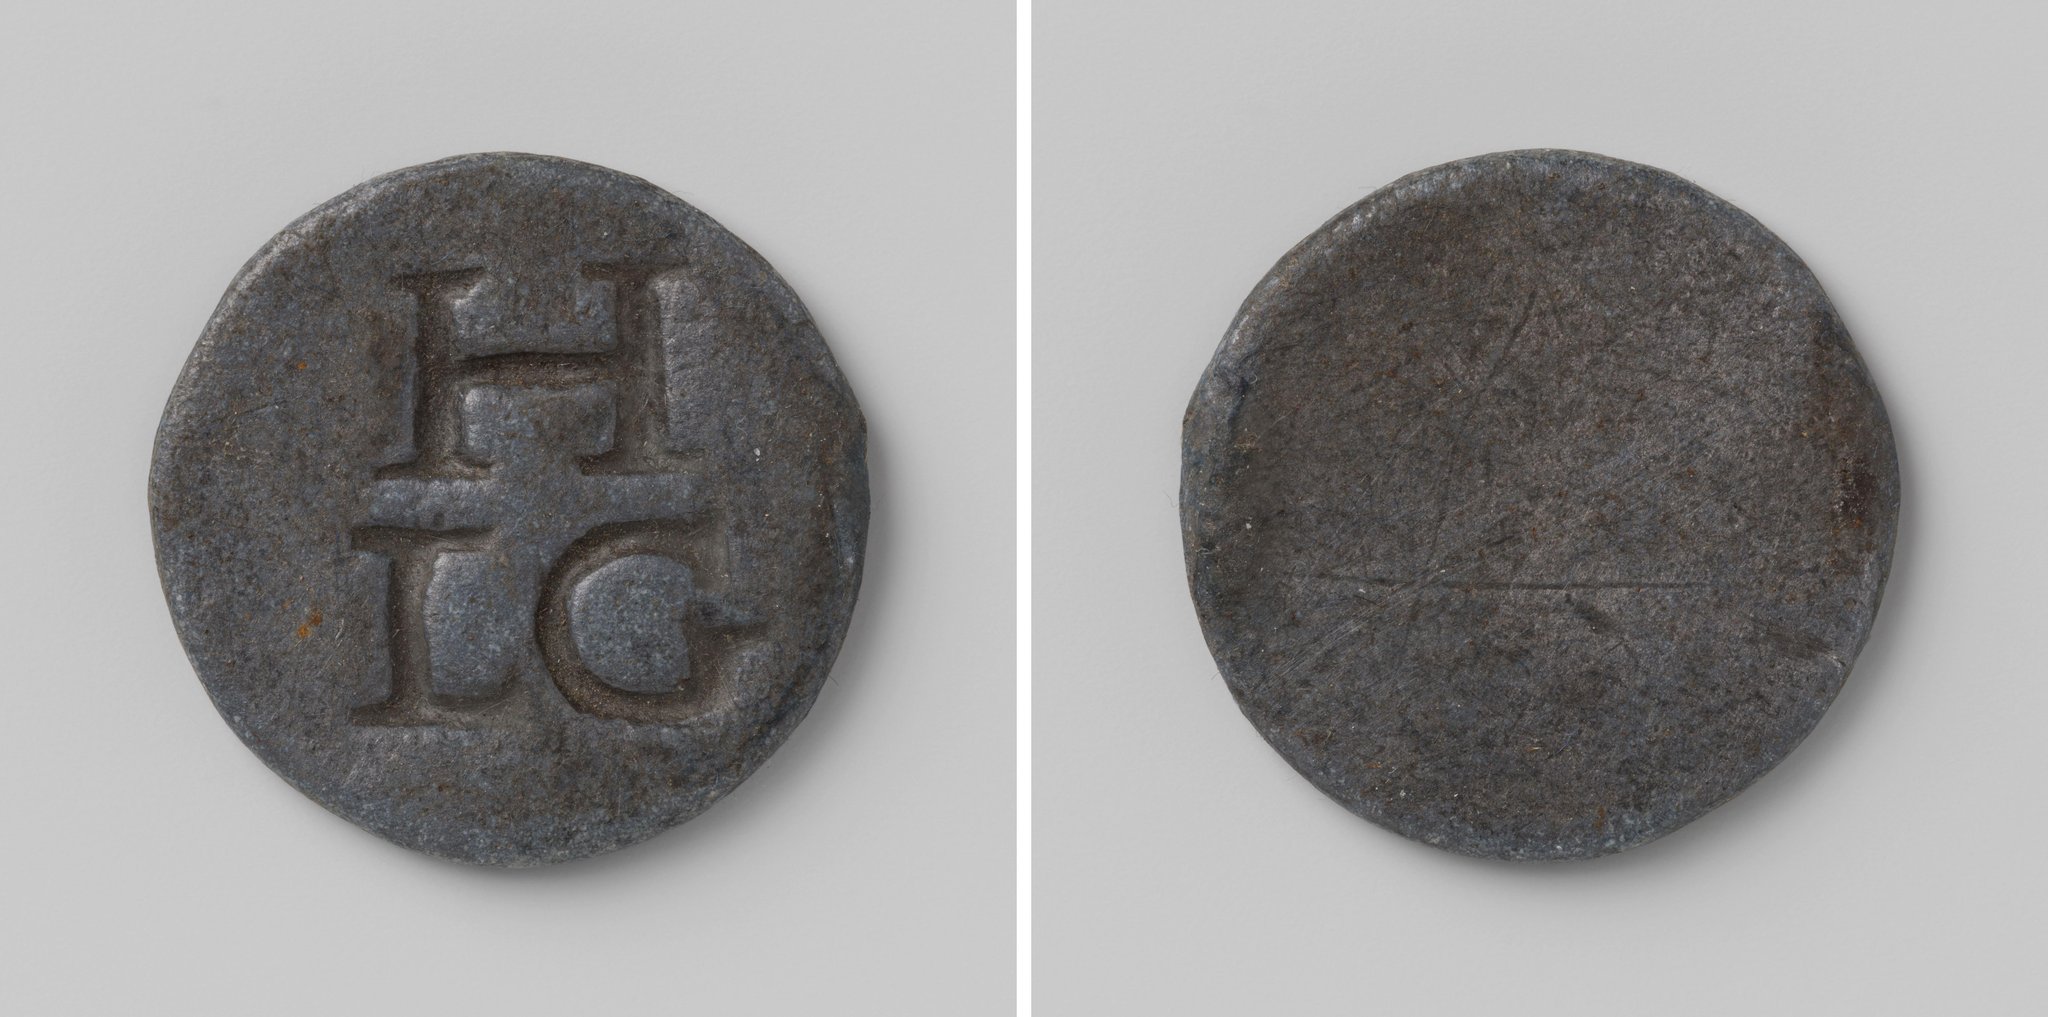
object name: communion token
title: Hersteld Lutherse Gemeente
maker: rensen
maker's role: loodgieter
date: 1791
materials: lead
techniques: casting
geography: amsterdam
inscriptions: inscription: ‘H/ LG’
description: Eenzijdige loden penning. Voorzijde: letter H boven letters LG. Keerzijde: blanco.